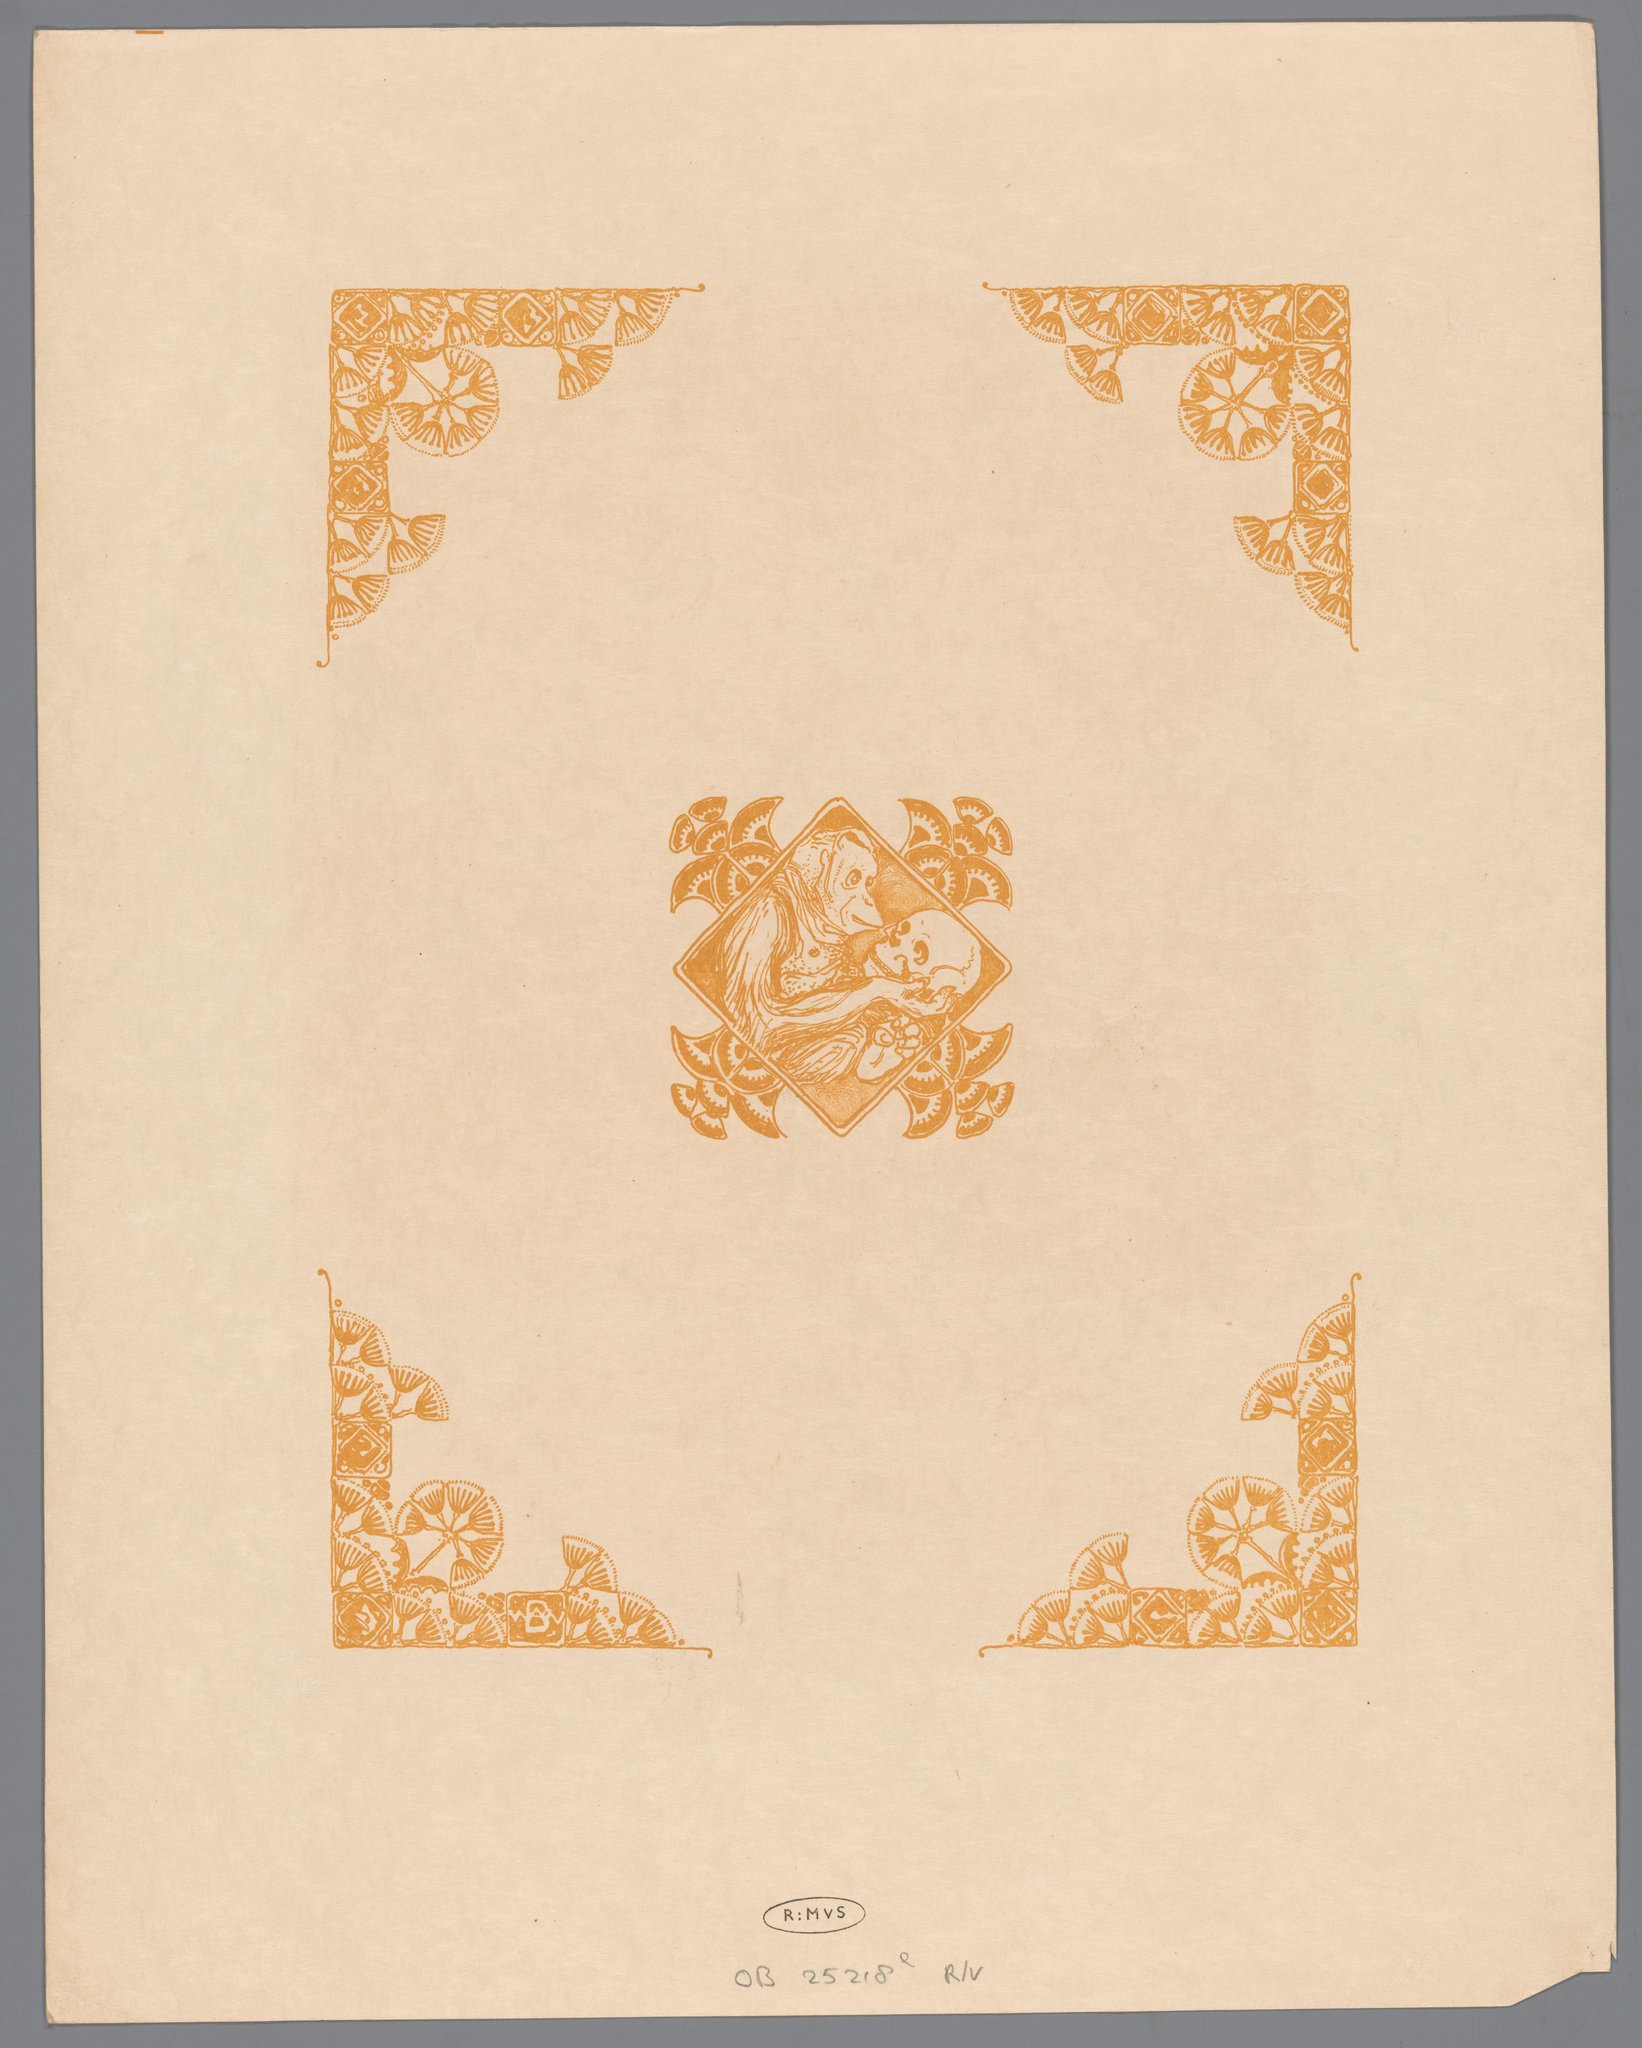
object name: book illustration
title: Ornamentiek en een aap met een schedel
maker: bernard willem wierink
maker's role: draughtsman, print maker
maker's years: 1856-1939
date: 1910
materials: paper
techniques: lithograph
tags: fable of reynard the fox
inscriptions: collector's mark: Lugt 2228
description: Prent gebruikt in: Streuvels, Stijn (Frank Lateur). Reinaert de Vos naar verschillende uitgaven van het middeleeuwsche epos. Amsterdam: L.J. Veen, 1910.